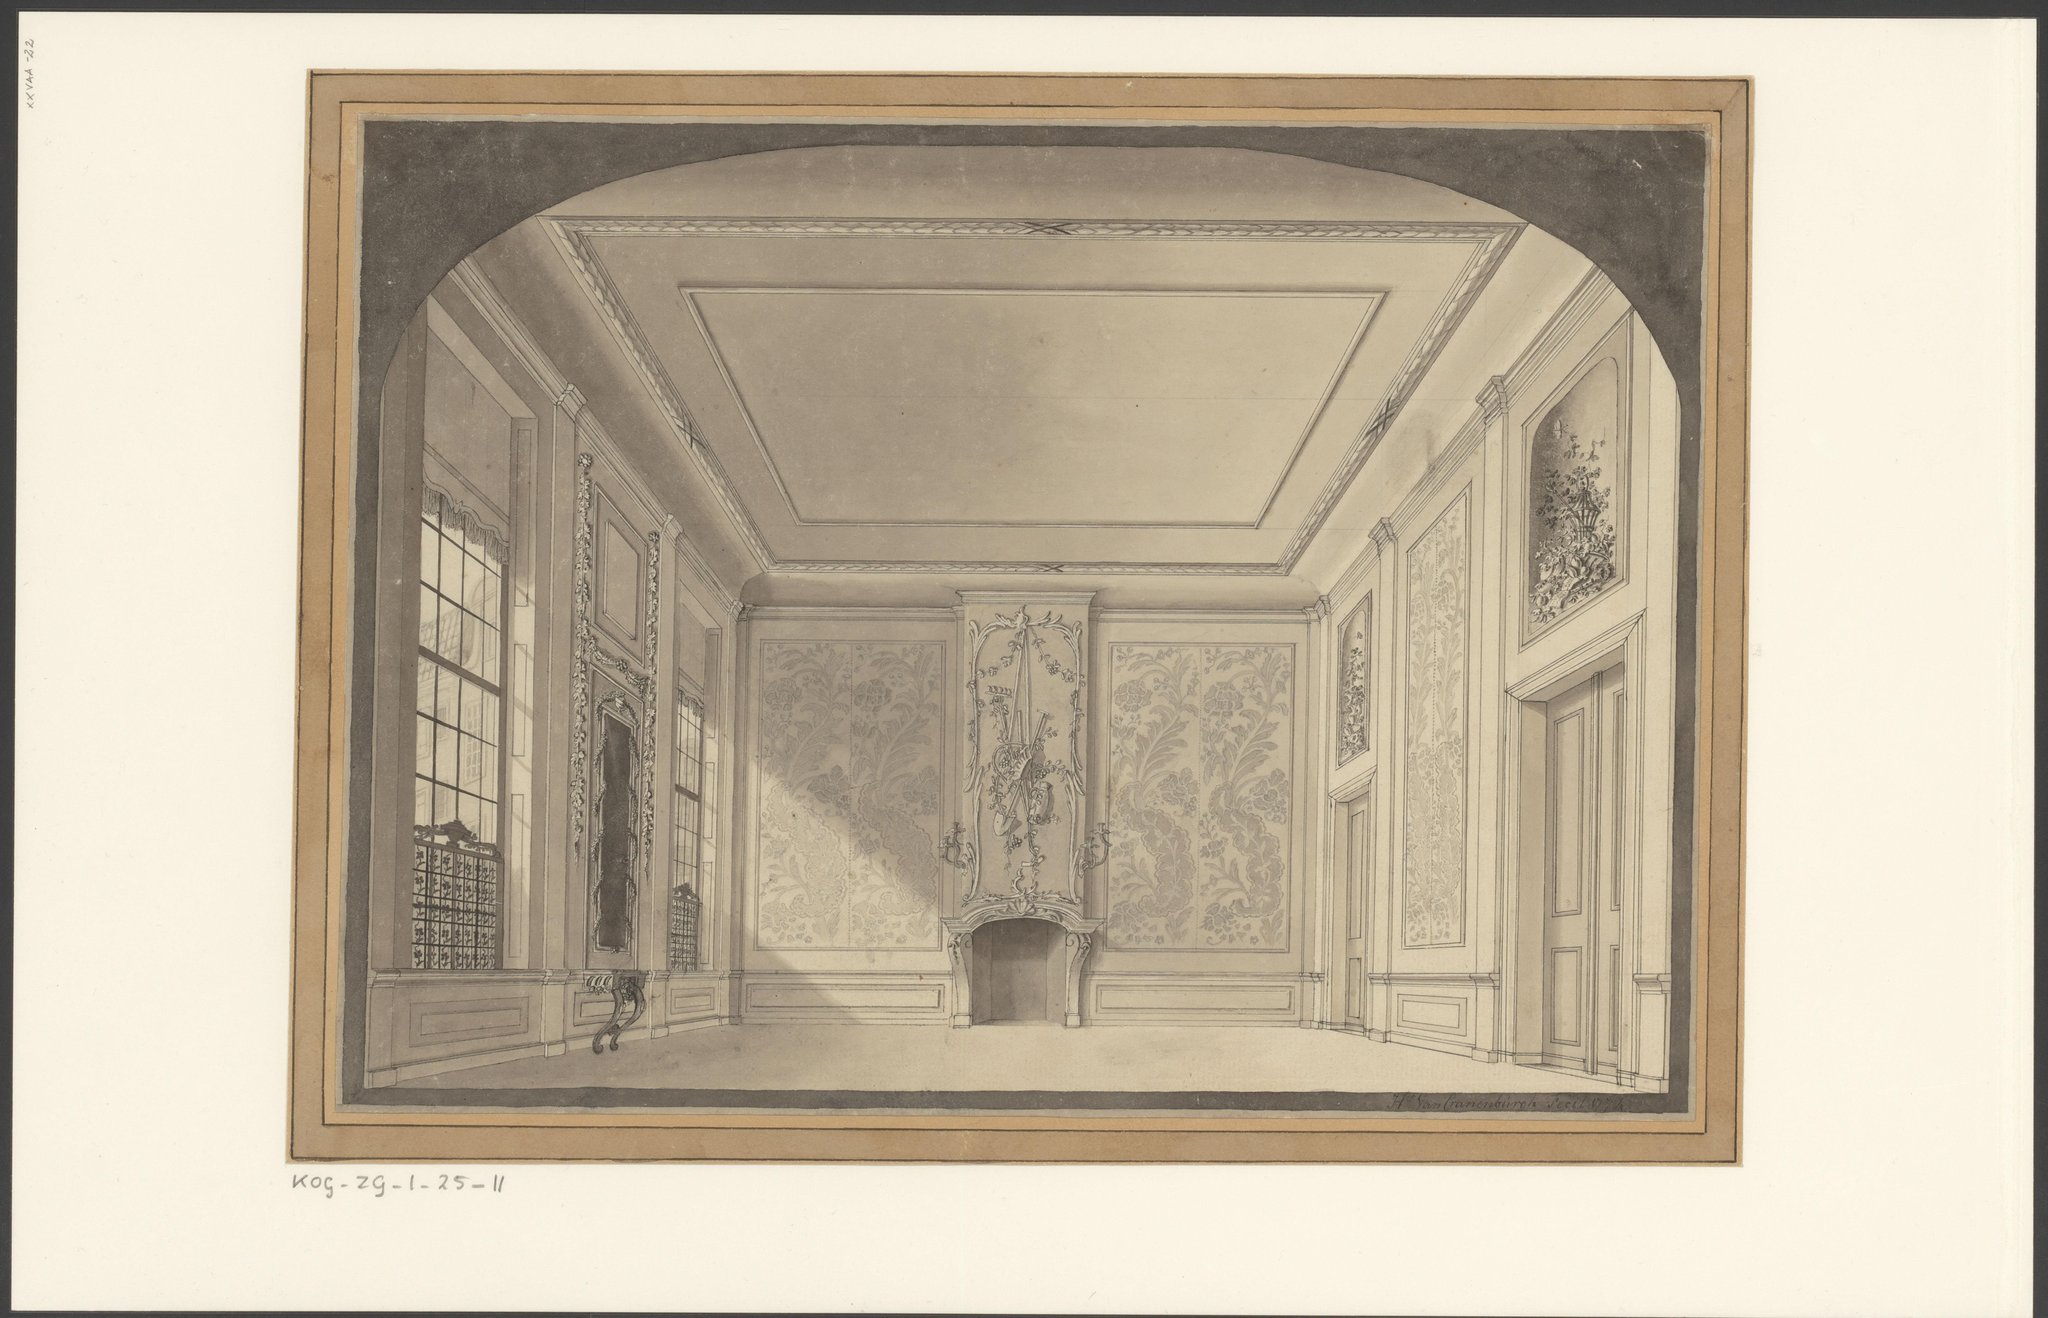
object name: drawing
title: Zaal van een huis te Amsterdam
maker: hendrik van cranenburgh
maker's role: painter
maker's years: 1754-1832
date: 1774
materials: ink, paper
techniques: brush, pen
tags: drawing-room, 'salon', interior of the house, wall-covering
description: Onderwerpsrubrieken binnen de Atlas Zeden en Gewoonten: Zeden en Gewoonten in Engeren Zin, De Woning, Binnenhuizen, Kamerbetimmering.